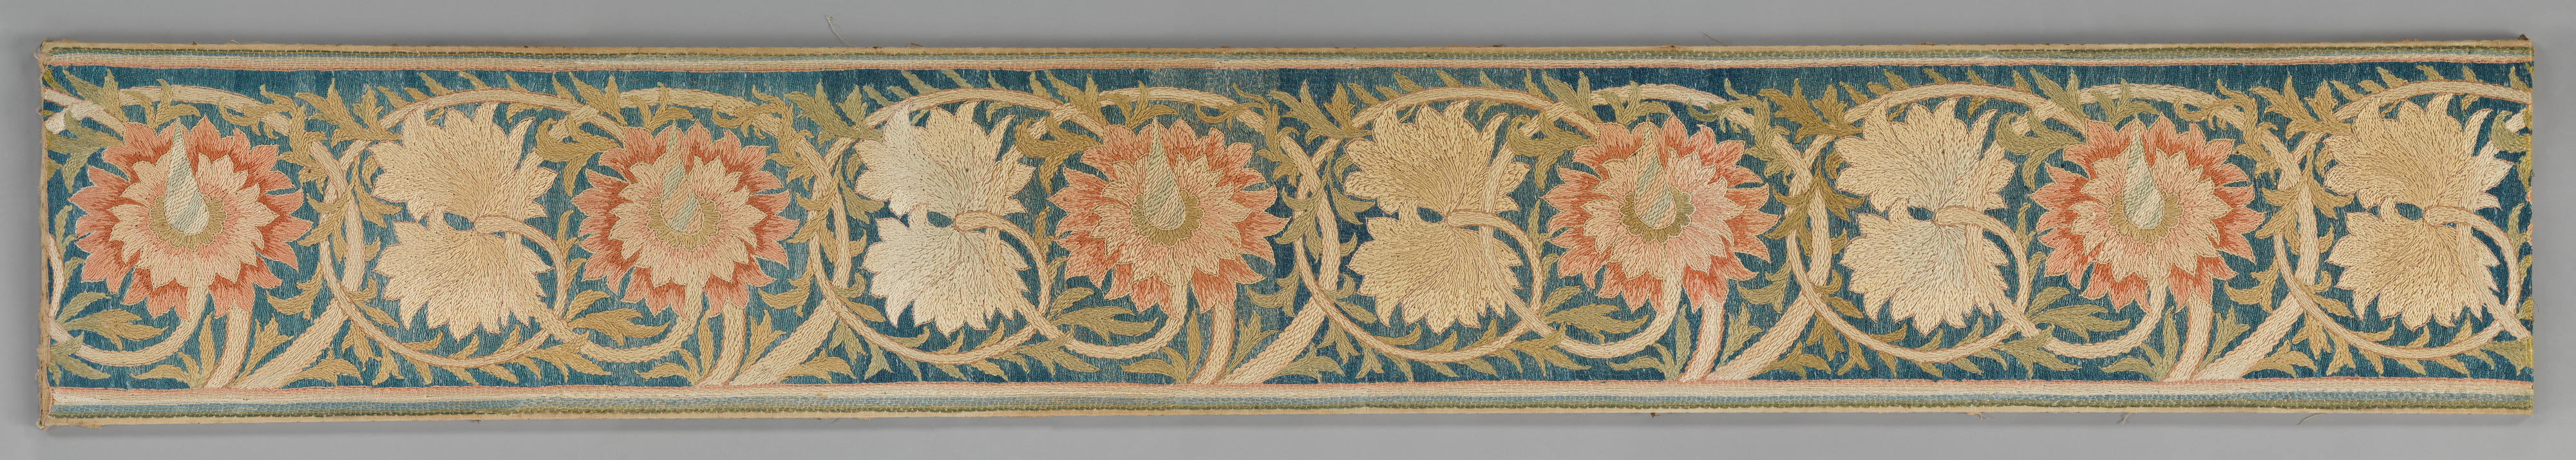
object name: border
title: Five pink flowers with foliated tendrils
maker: morris & company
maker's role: maker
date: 1876-1900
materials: linen, silk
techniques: embroidery